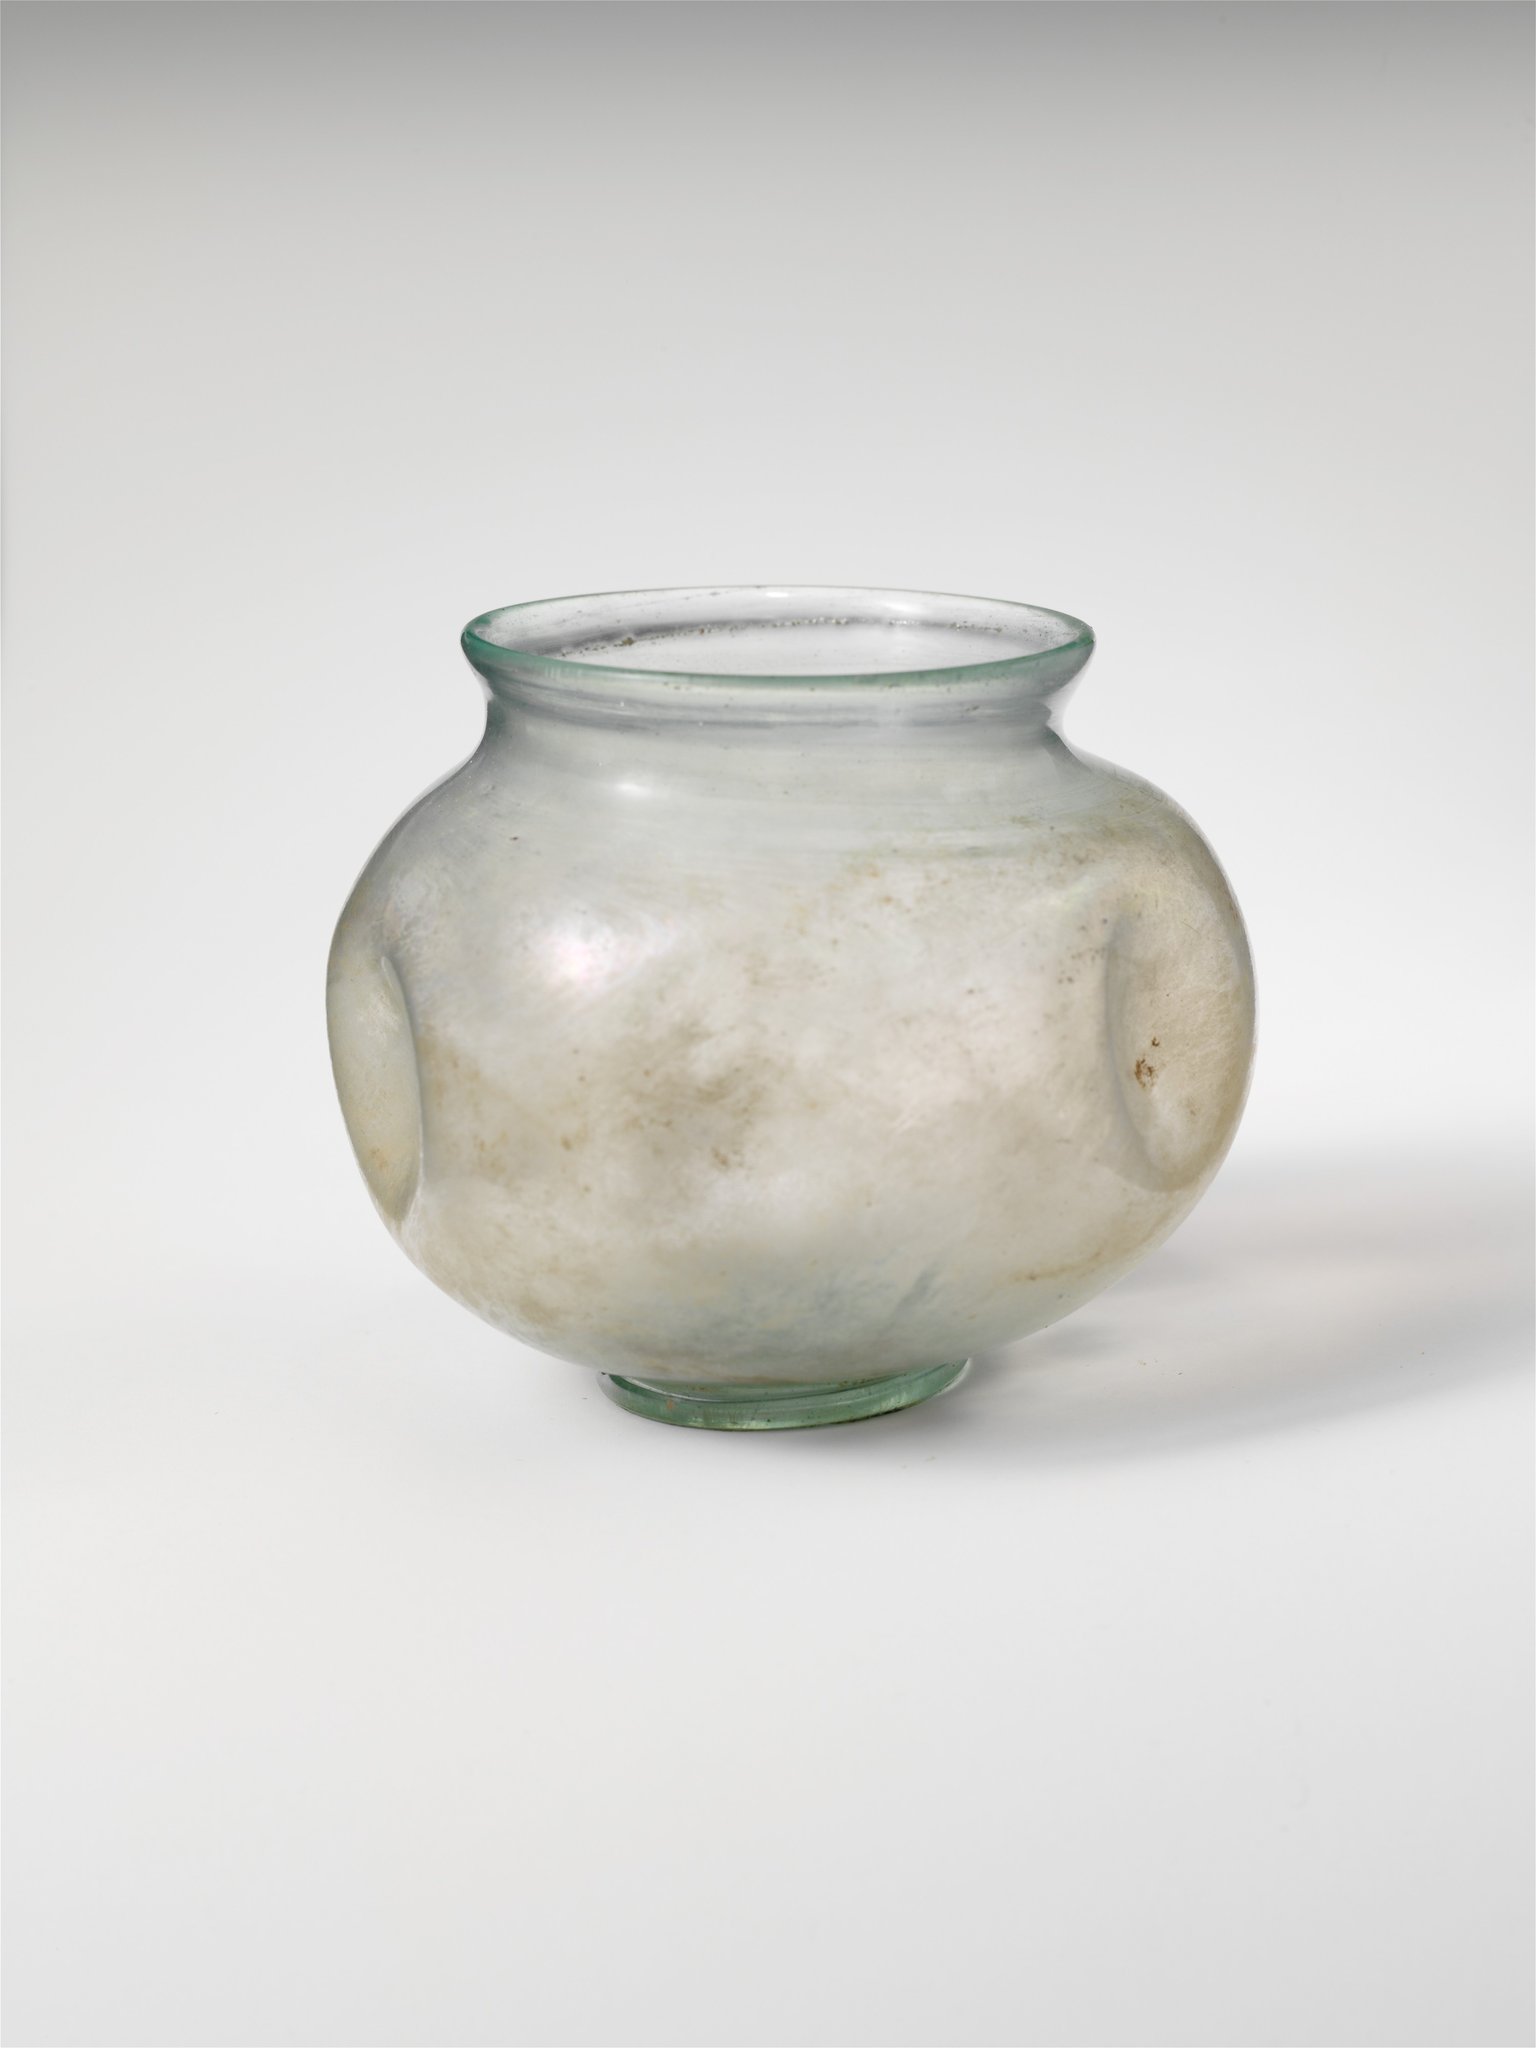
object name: jar, indented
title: Glass jar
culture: roman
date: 101-300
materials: glass